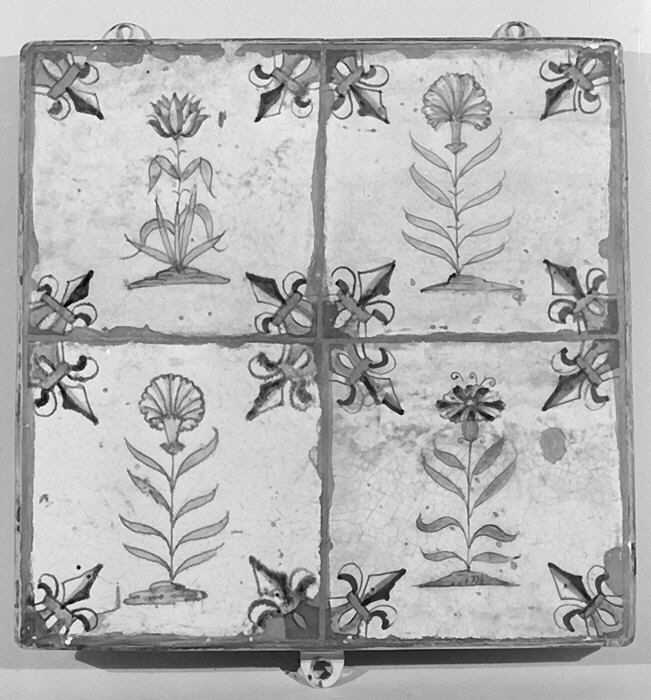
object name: tile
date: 1640-1660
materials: earthenware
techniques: glazing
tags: flowers